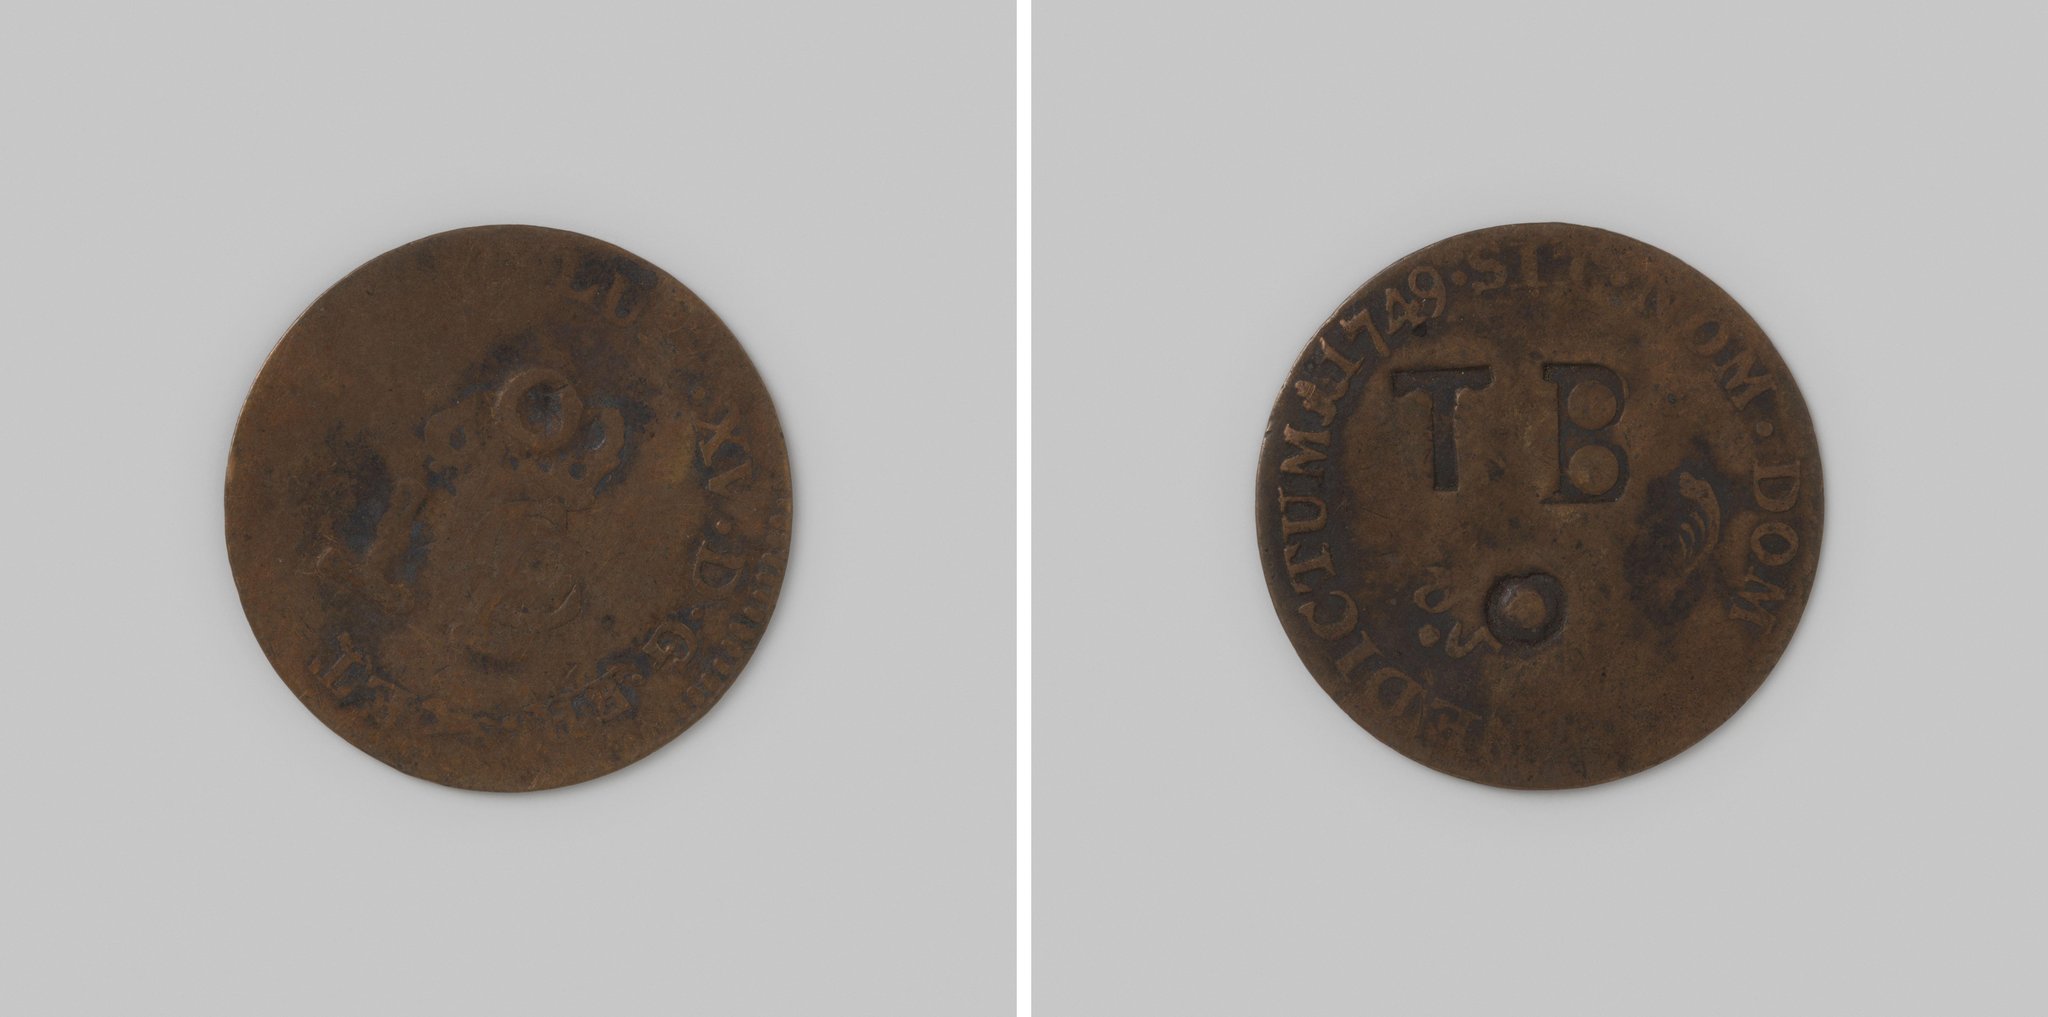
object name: coin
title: 2 sols uit Frankrijk van koning Lodewijk XV, ingestempeld met letter C [=colonies] en vervolgens met de letters T, B en O [=Tobago]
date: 1749-1780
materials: silver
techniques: striking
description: Koper-zilveren munt. Voorzijde: tussen drie lelies gekroond monogram van de koning, waarop een klop: letter C. Keerzijde: gekroond versierd monogram van de koning, waarop een klop: letters T,B en O. Gladde rand.